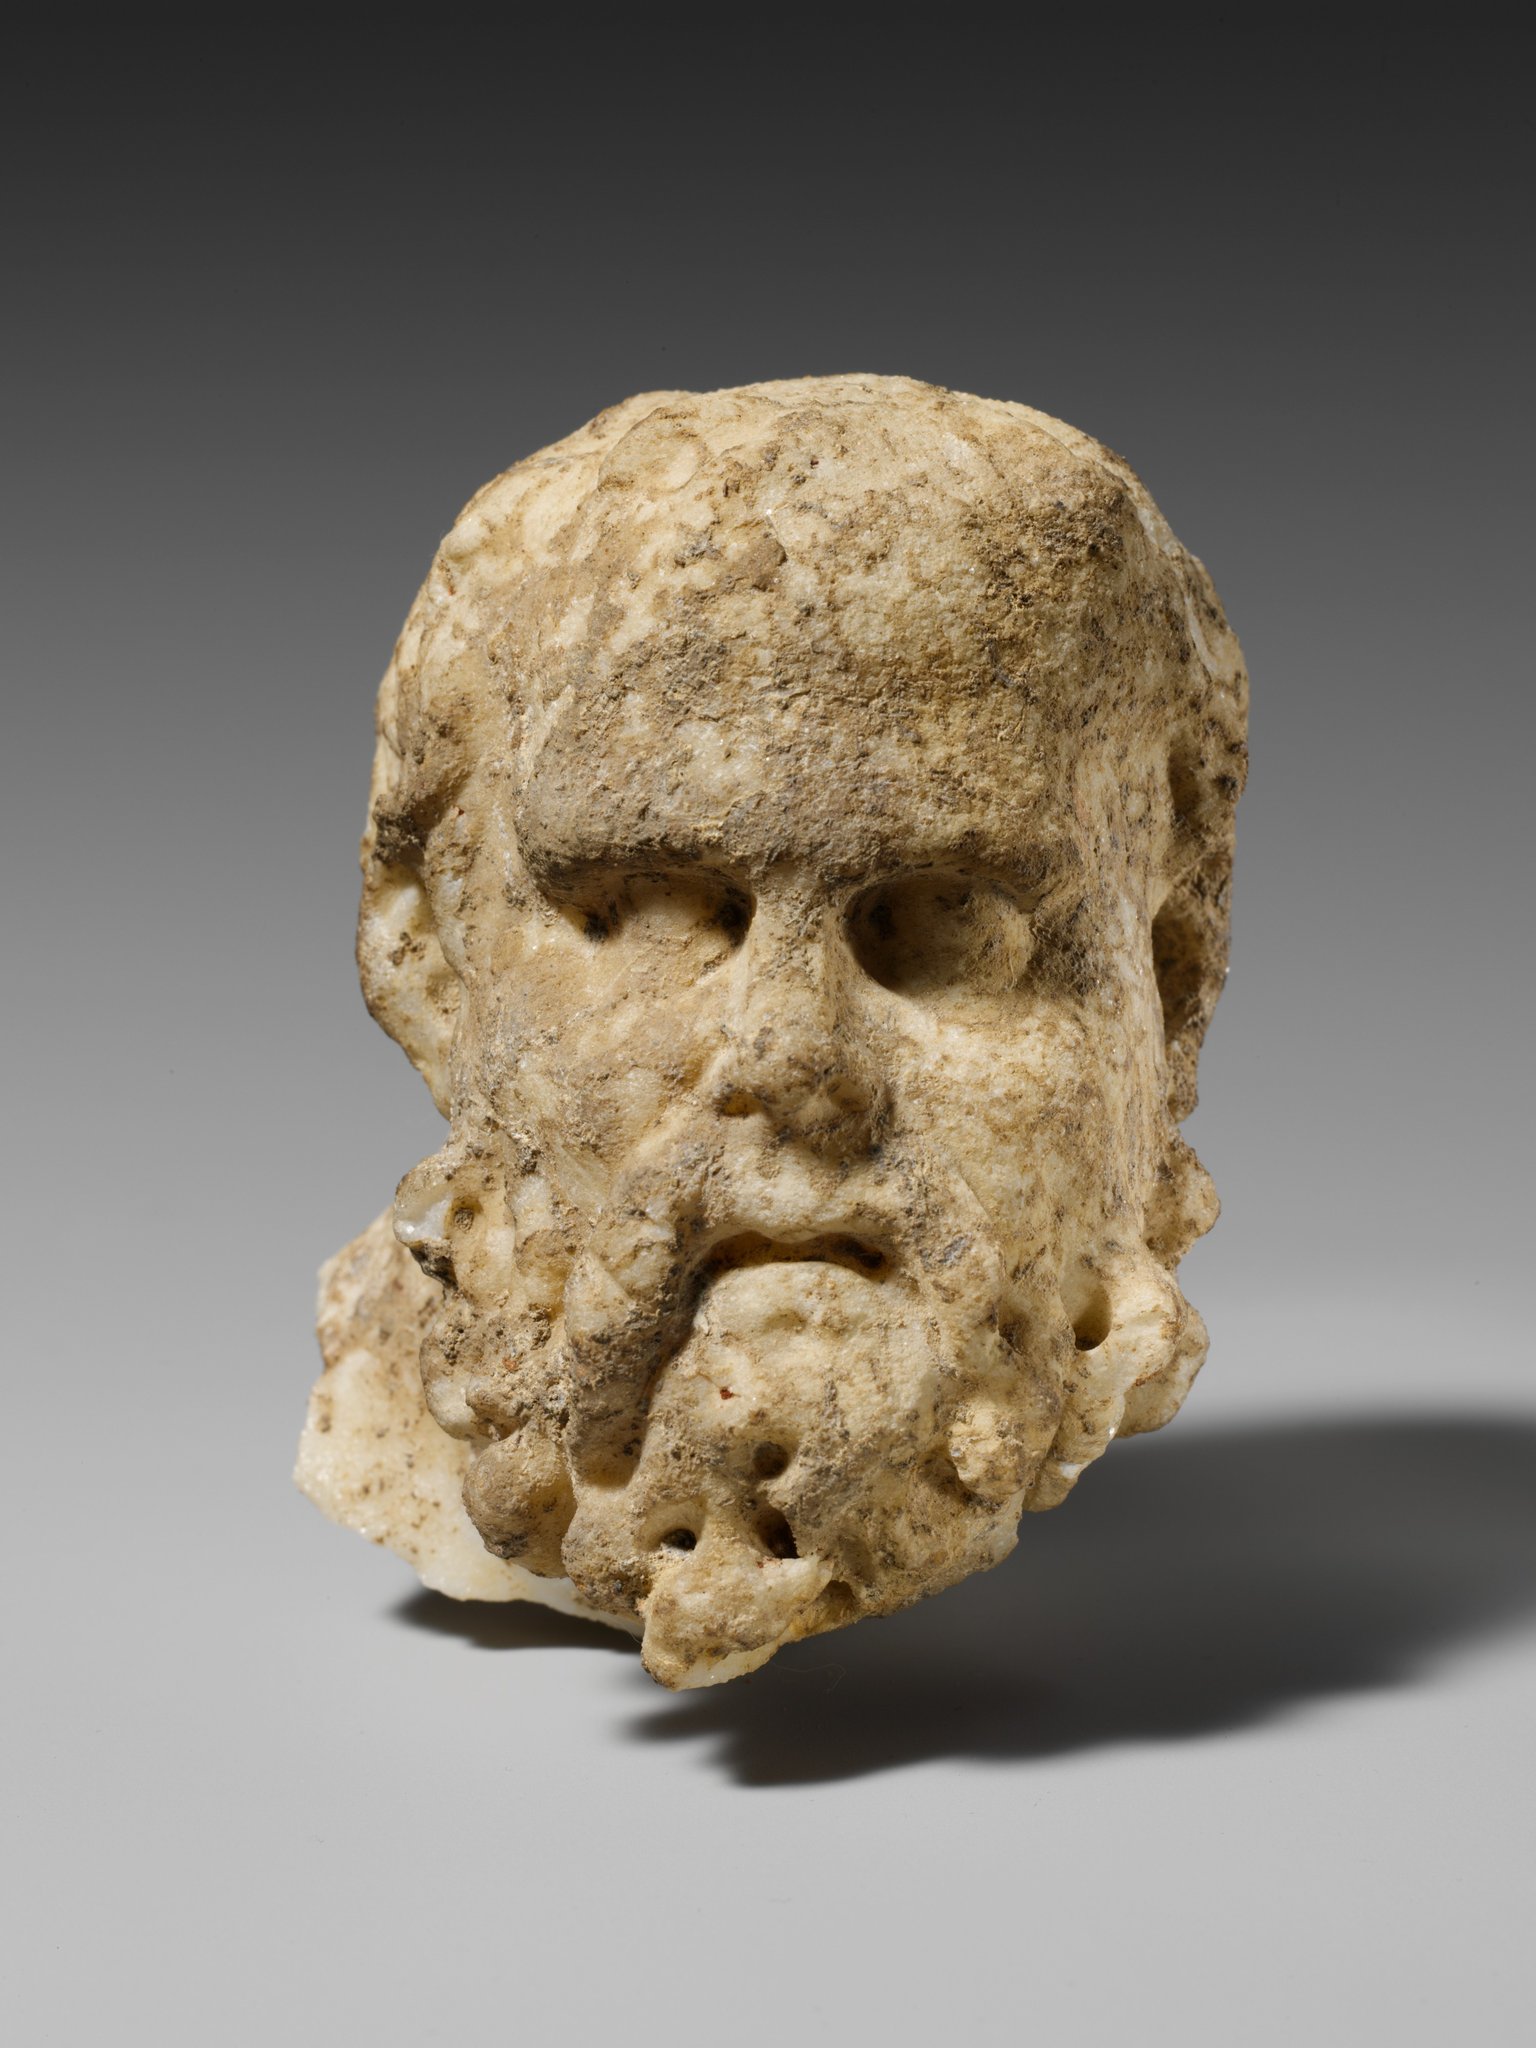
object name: head of an old man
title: Marble head of a bearded man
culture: roman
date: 1-100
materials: marble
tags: heads,men